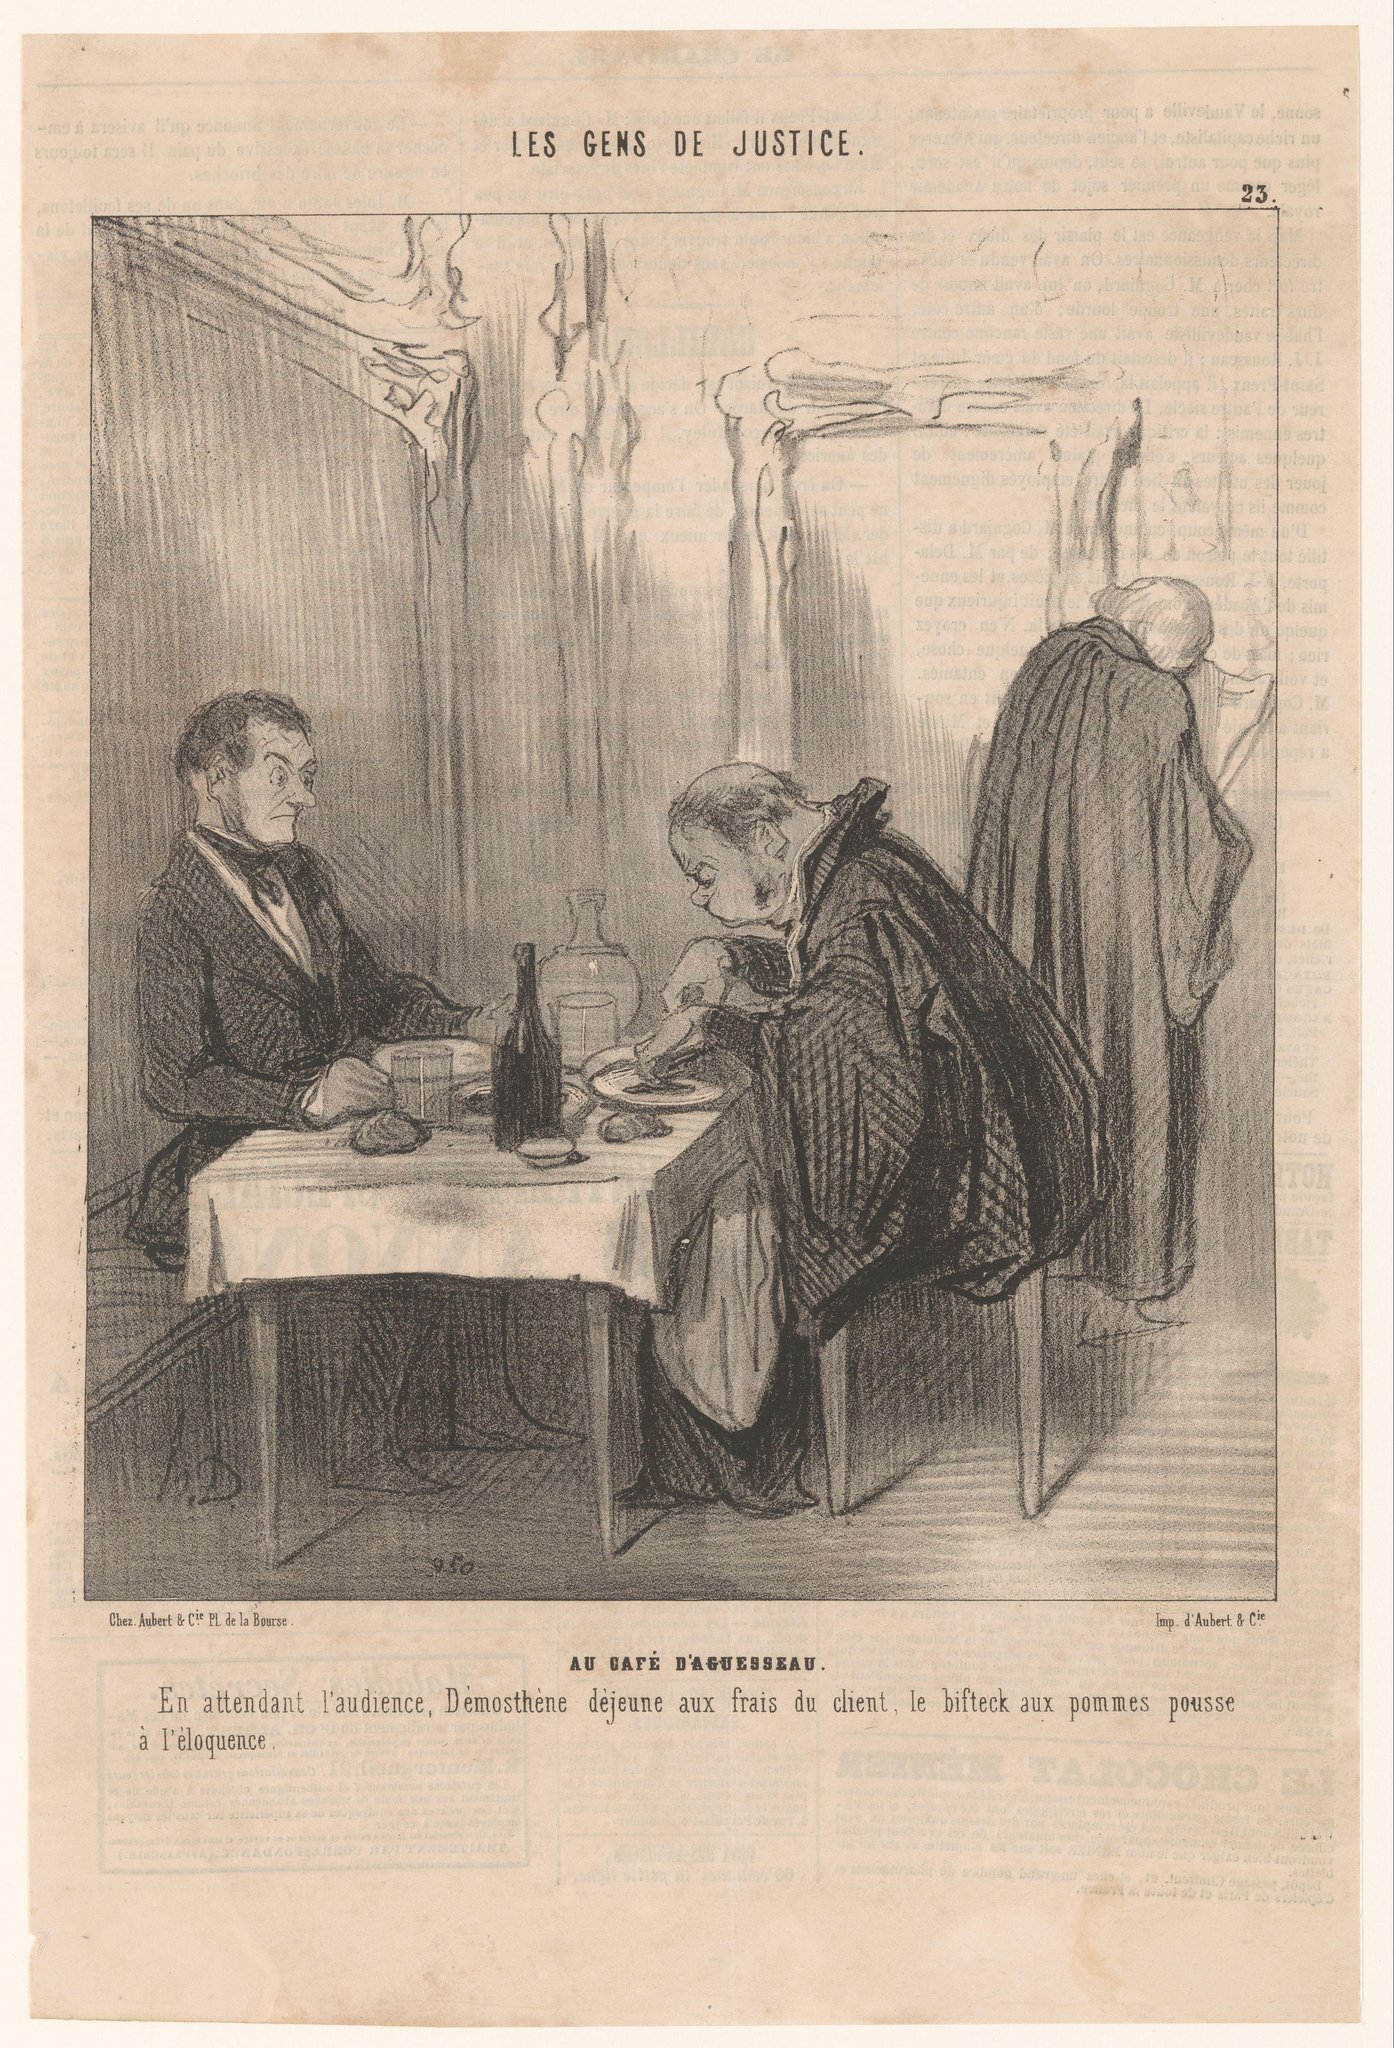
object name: cartoon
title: Les gens de justice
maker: honoré daumier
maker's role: draughtsman, painter, print maker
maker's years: 1808-1879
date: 1846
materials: paper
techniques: lithograph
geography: paris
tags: caricatures (human types), lawyer, attorney at law, restaurant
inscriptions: collector's mark: Lugt 2228a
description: Prent gebruikt voor: Le Charivari, 14-10-1846.